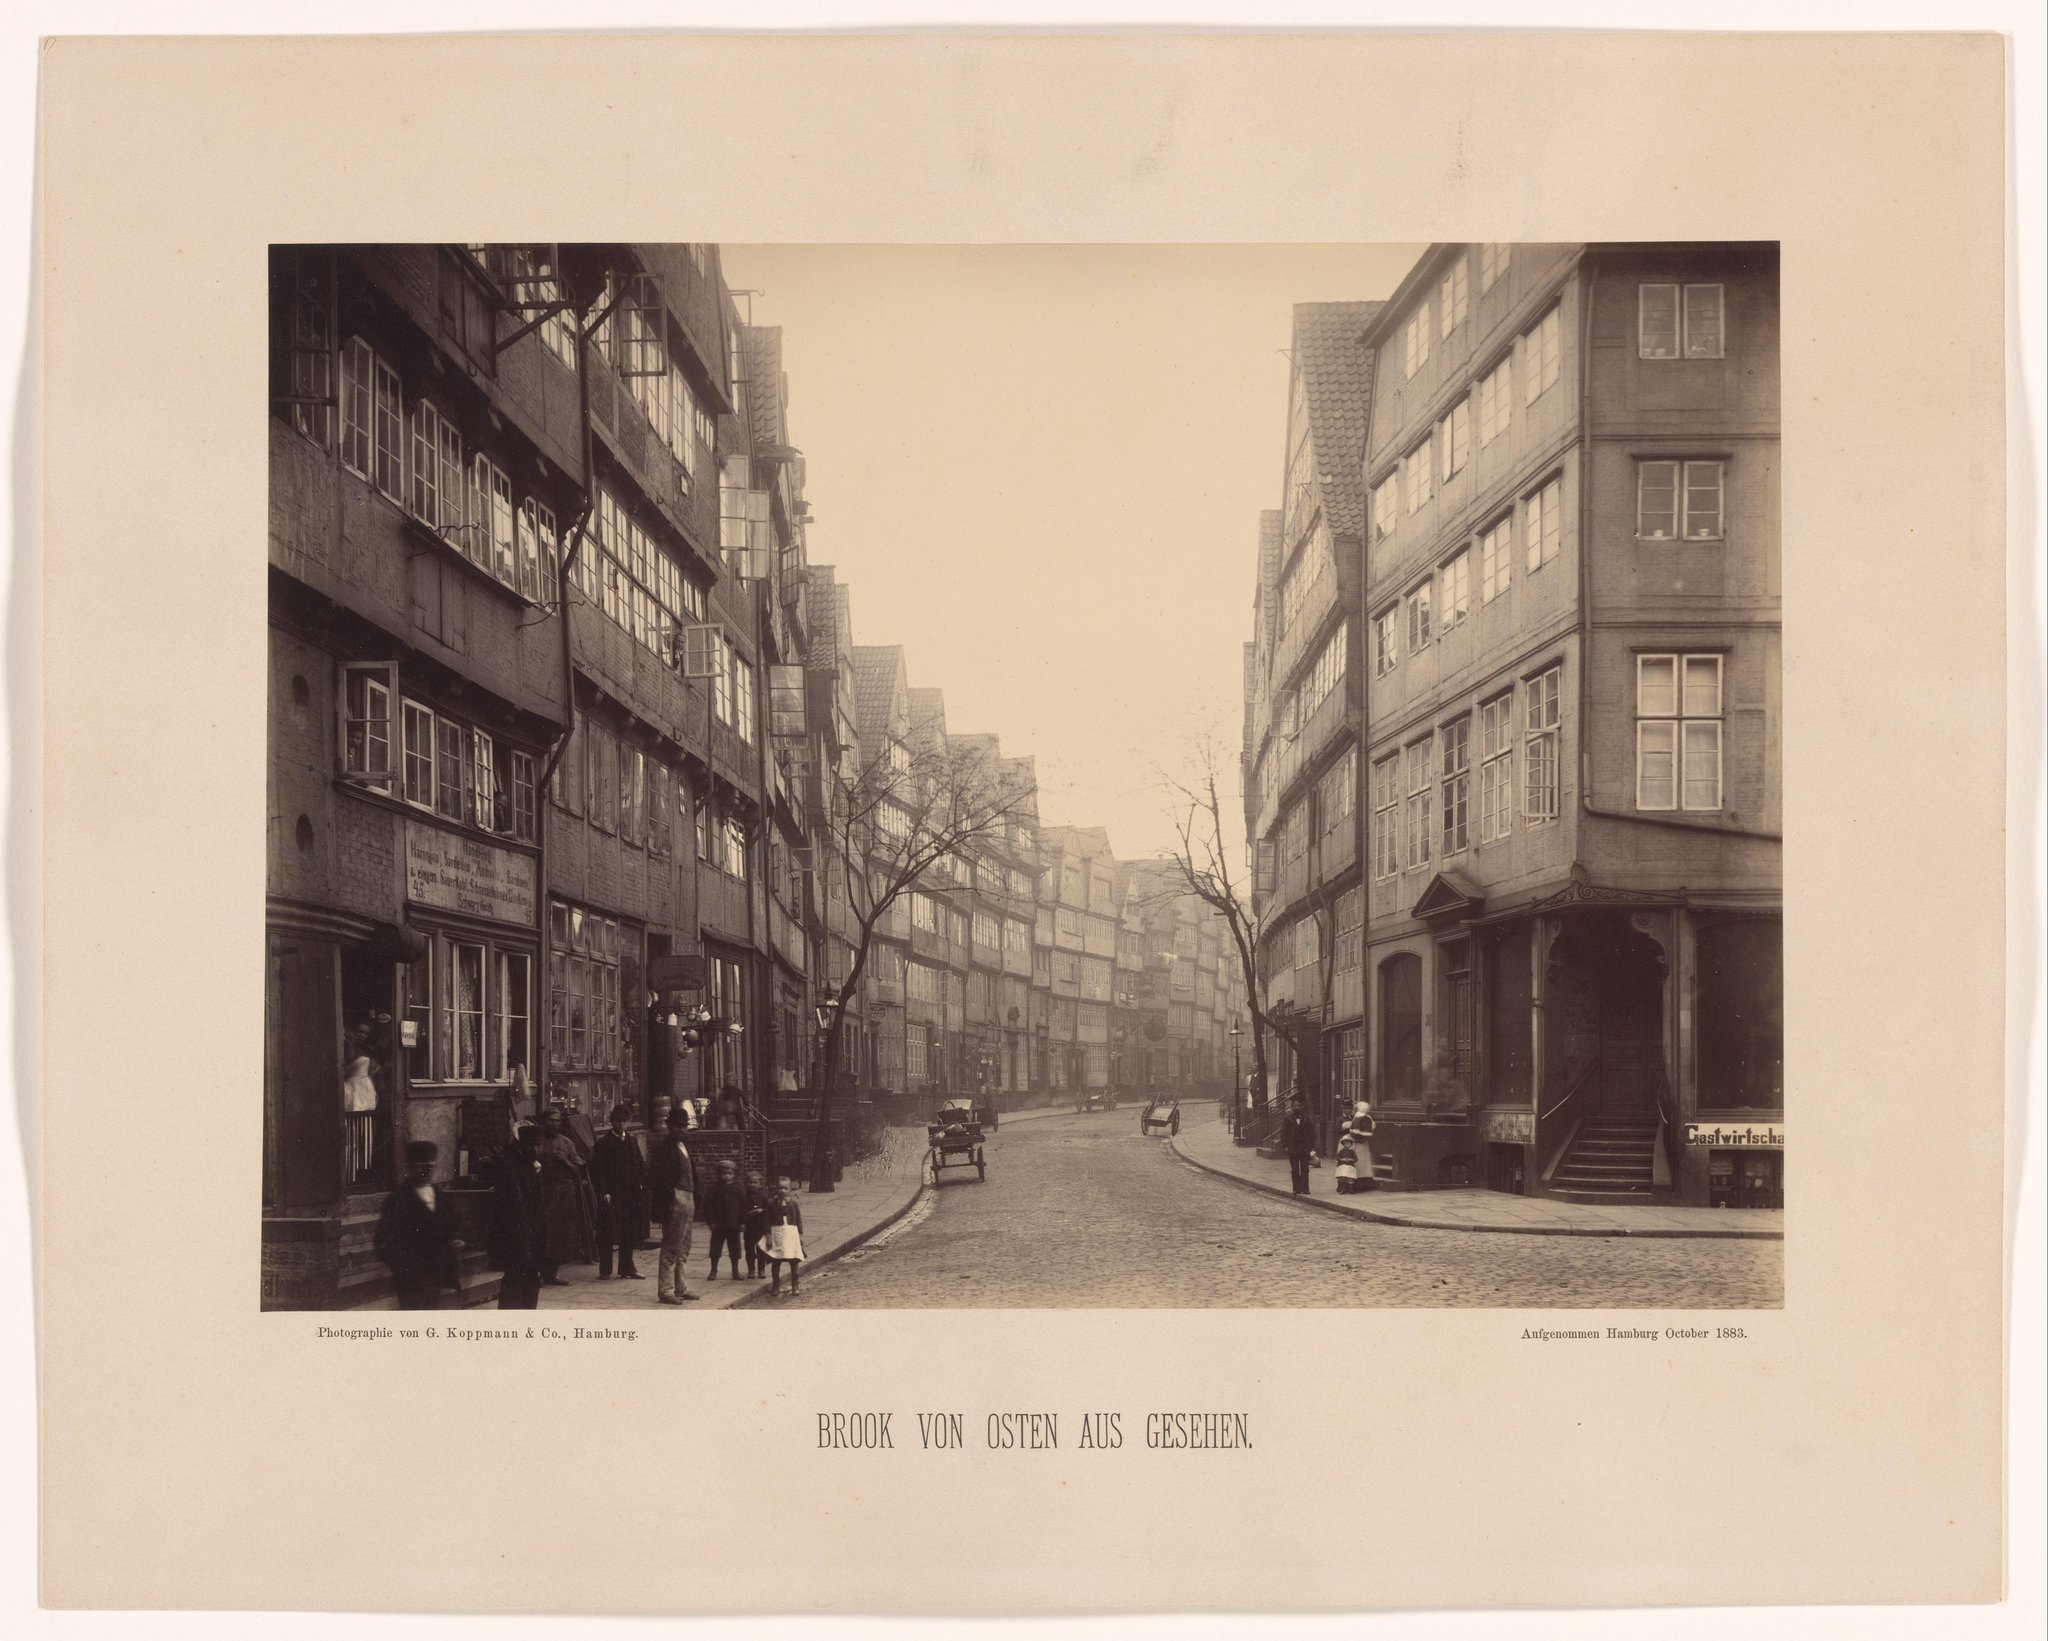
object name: photograph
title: Gezicht op Gasbrook in Hamburg vanuit het oosten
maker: georg koppmann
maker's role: fotograaf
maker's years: 1842-1909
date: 1810-1883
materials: cardboard, paper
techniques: albumen print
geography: hamburg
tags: urban housing, street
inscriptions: signature: ‘Photographie von G. Koppmann & Co., Hamburg.’, date: ‘Aufgenommen Hamburg October 1883.’, inscription: ‘25157/1c’